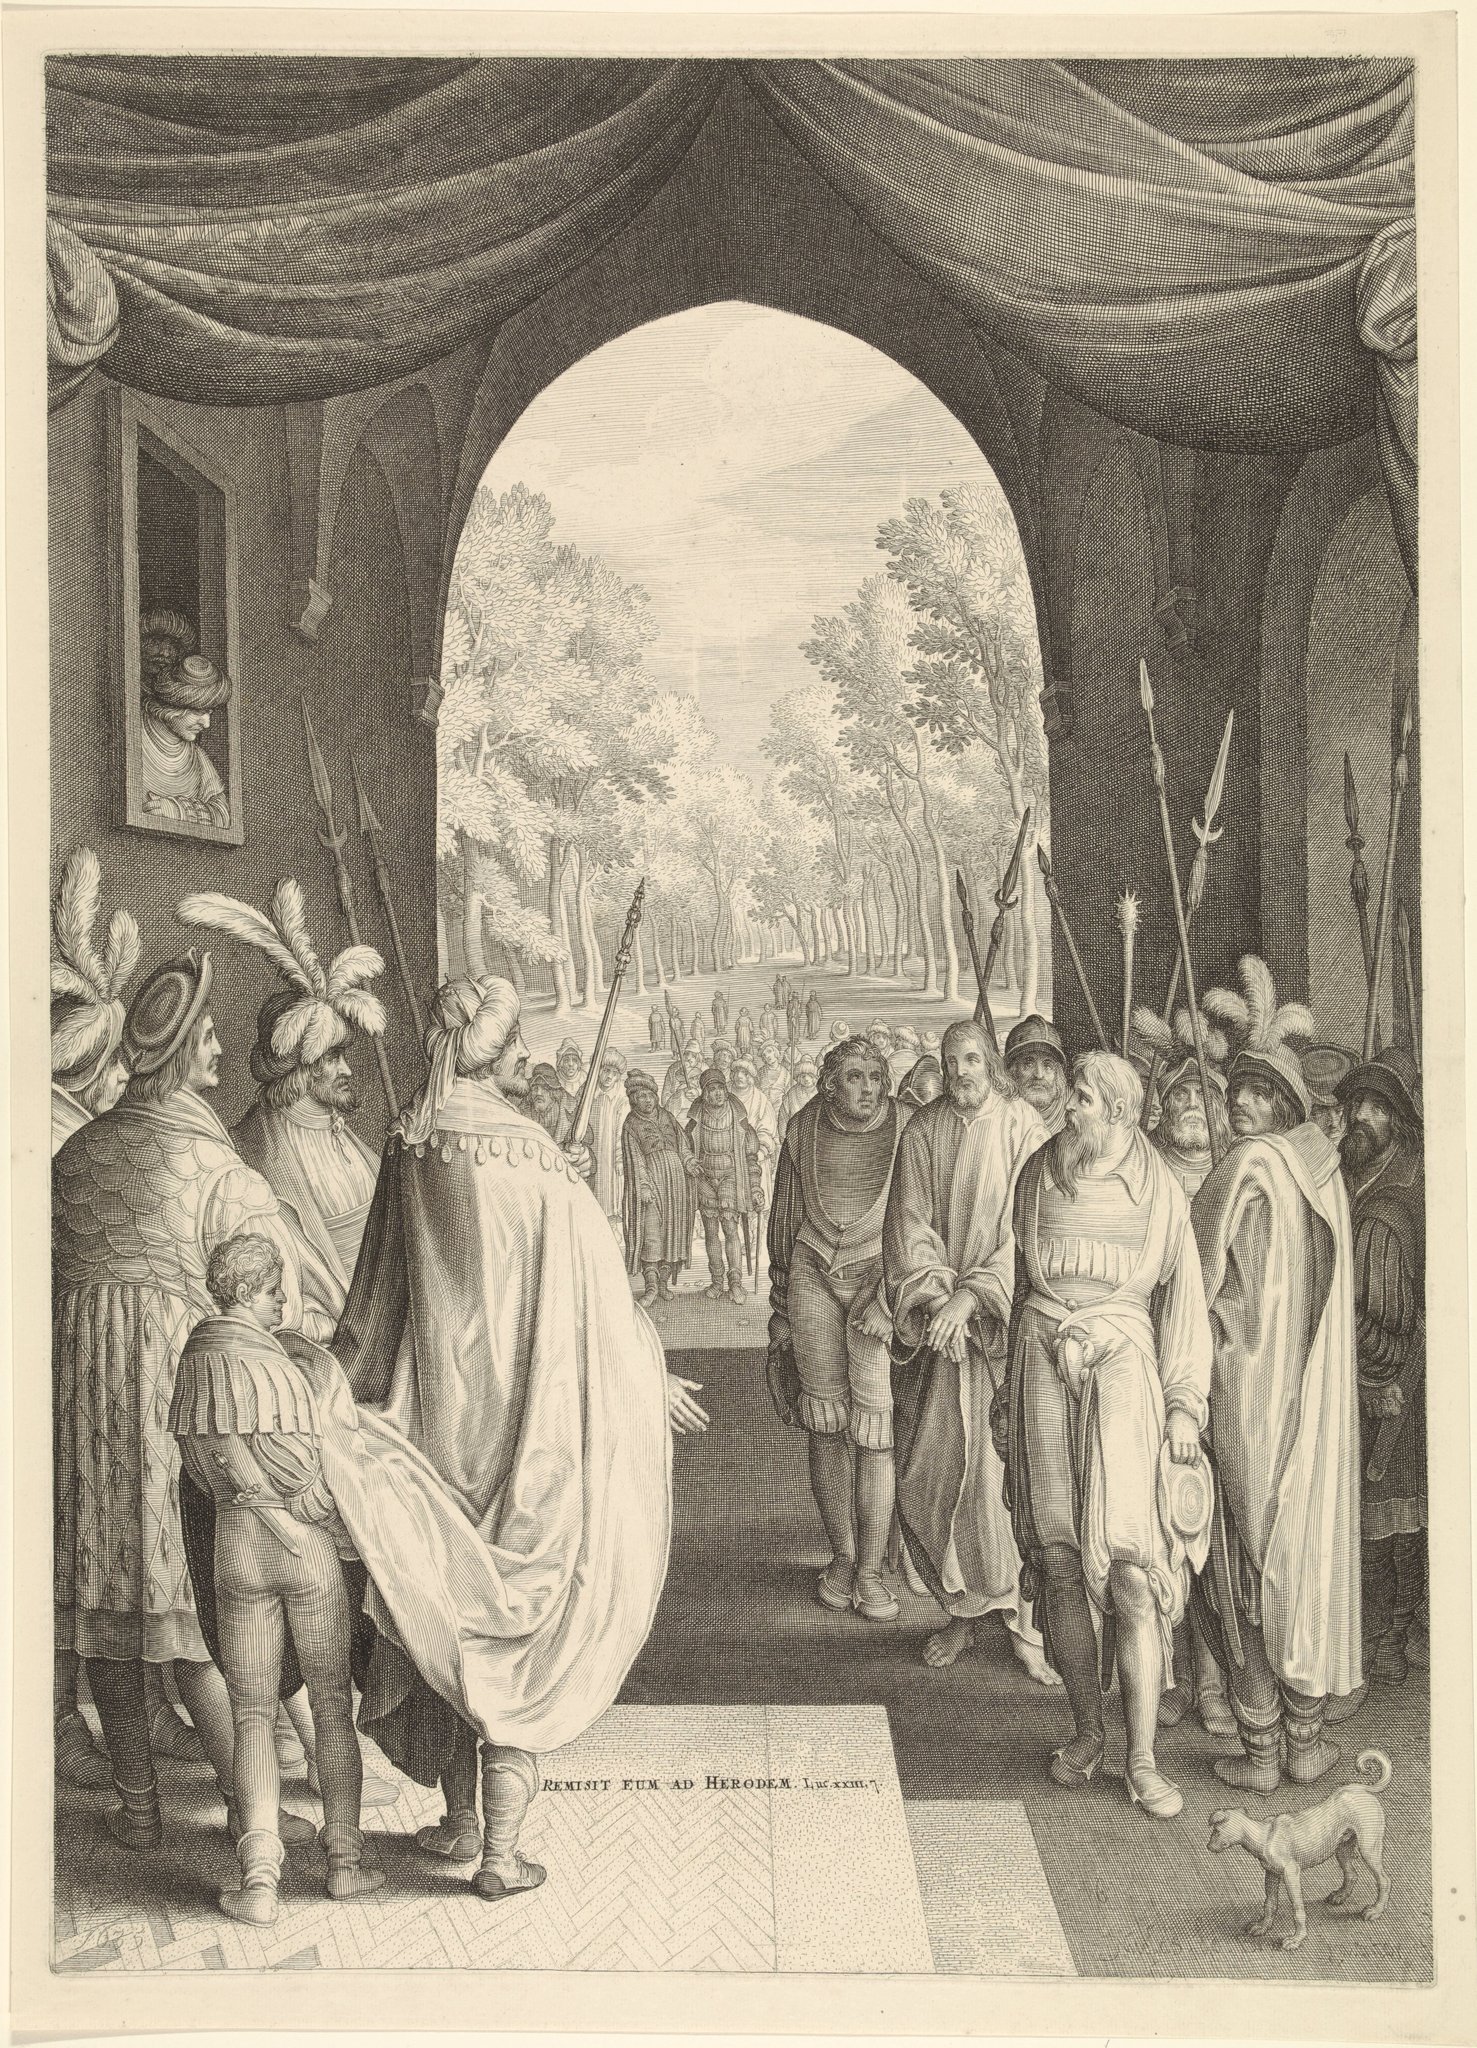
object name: print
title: Passie van Christus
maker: nicolaes de bruyn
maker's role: print maker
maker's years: 1571-1656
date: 1635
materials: paper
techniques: engraving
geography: rotterdam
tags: christ before king herod; sometimes a gorgeous robe is brought (luke 23:8-11)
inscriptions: date